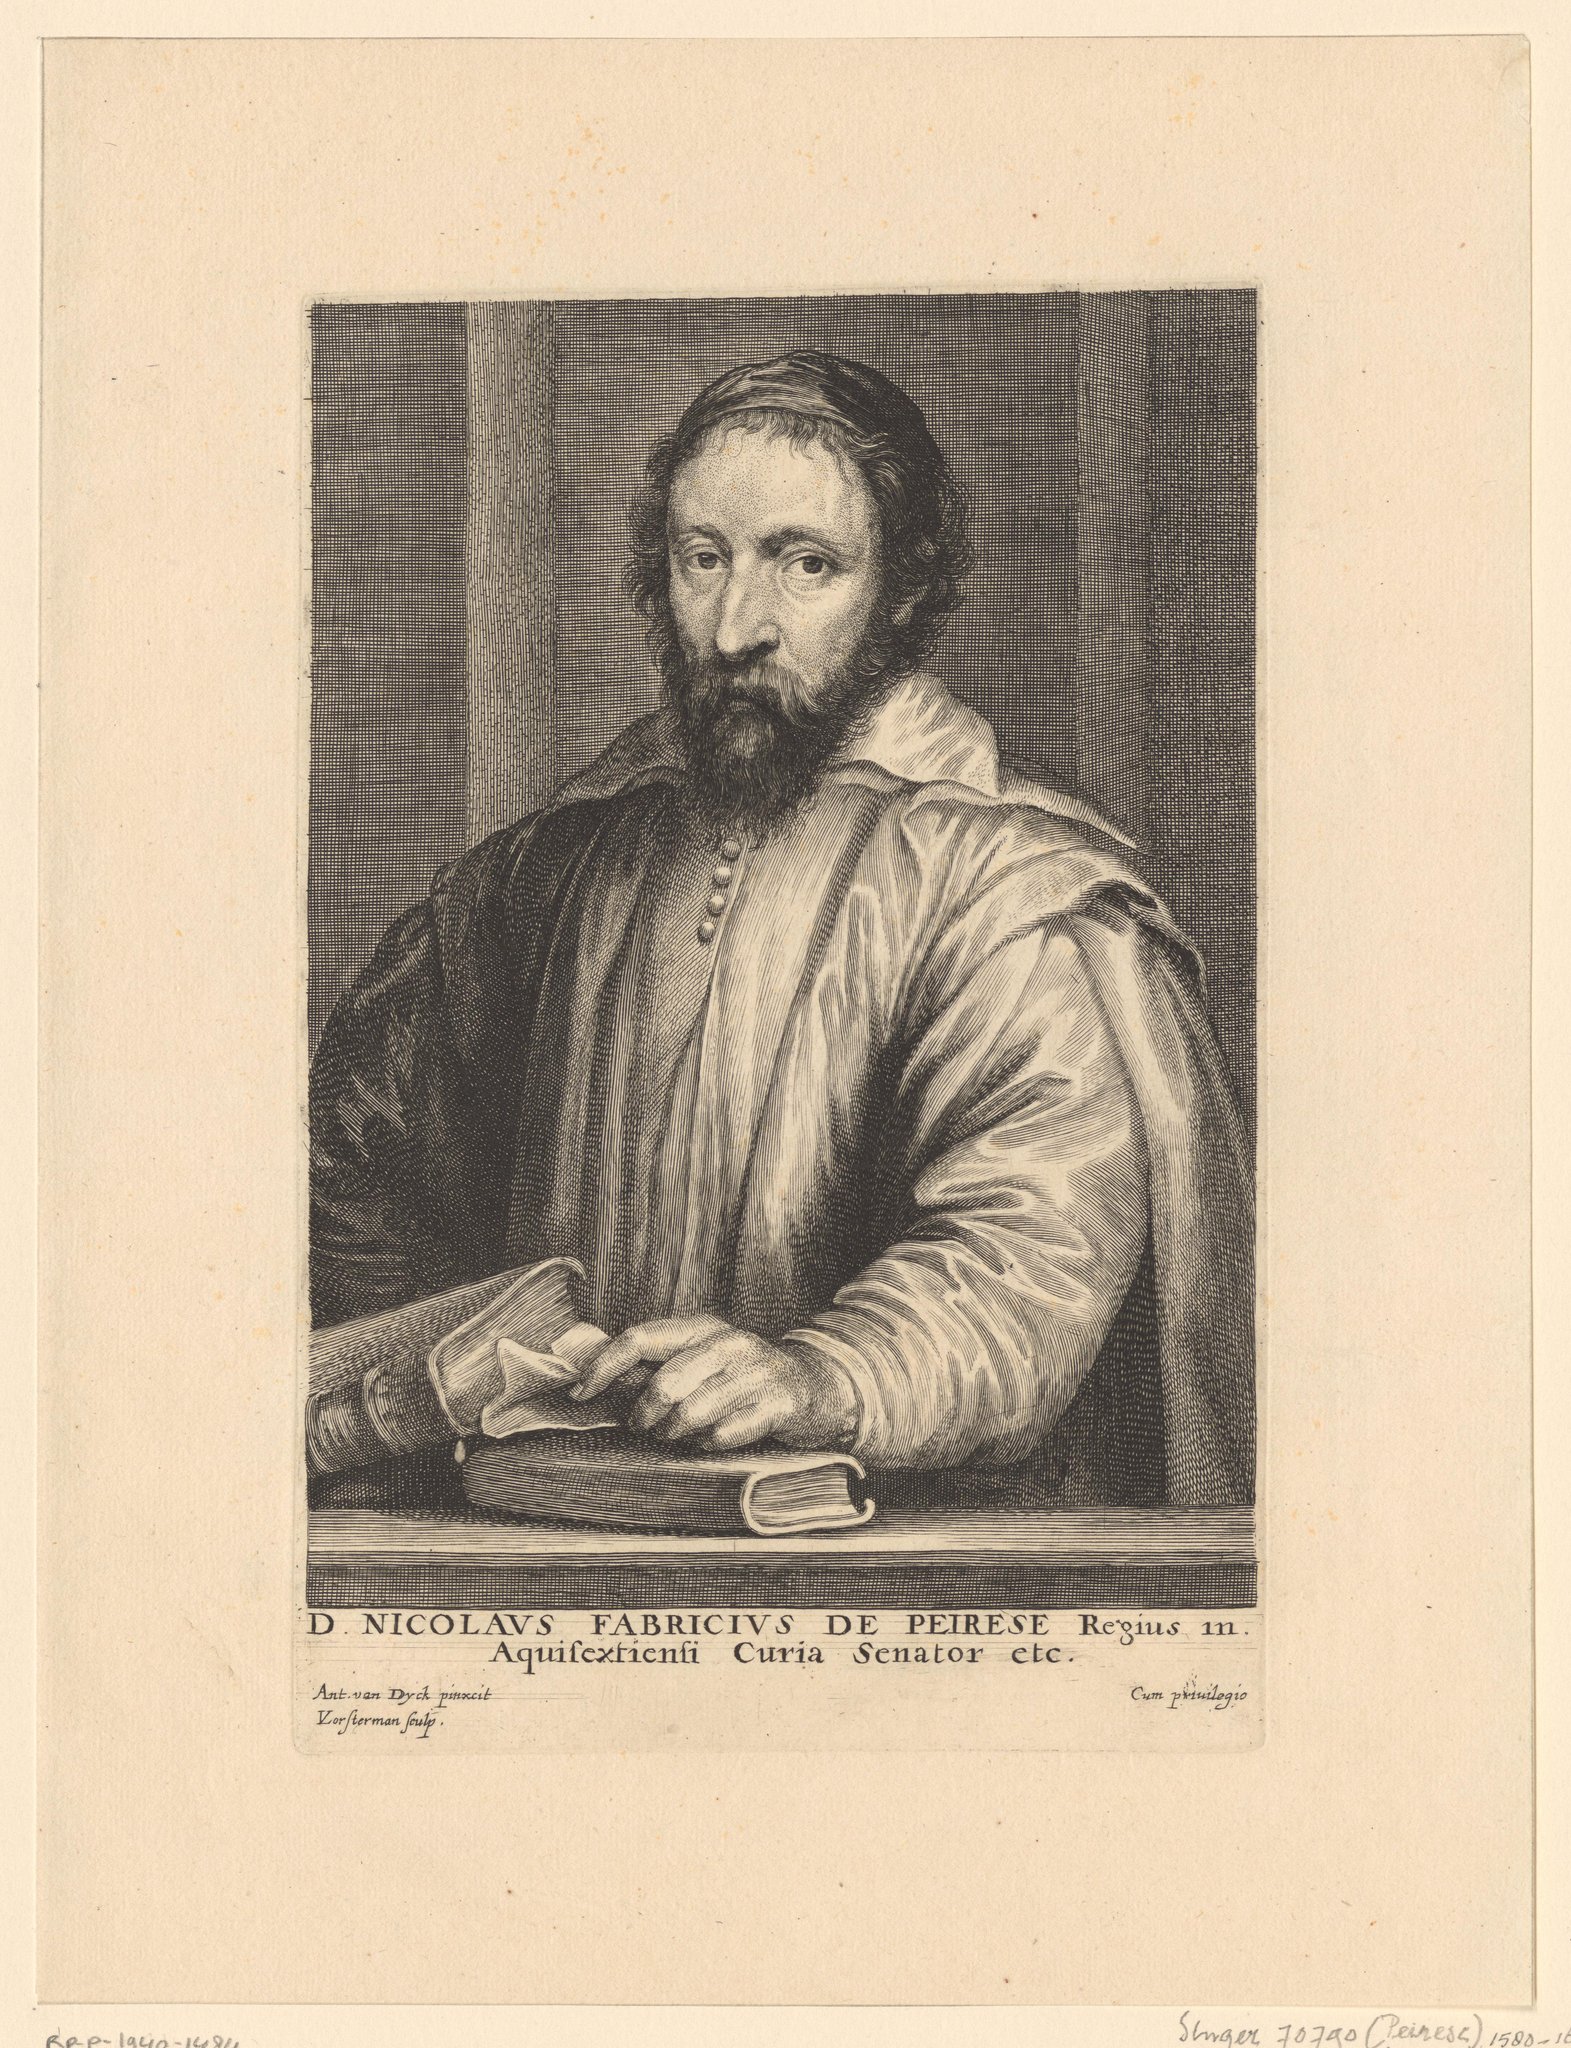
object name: print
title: Portret van Nicolas-Claude Fabri de Peiresc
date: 1645-1646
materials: paper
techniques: engraving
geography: antwerp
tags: nicolas-claude fabri de peiresc, adult man, historical persons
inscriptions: collector's mark: Lugt 2228, collector's mark: Lugt 2760, collector's mark: Lugt 2166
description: Prent mogelijk uit: Icones principum, virorum doctorum, pictorum, chalcographorum, statuariorum nec non amatorum pictoriae artis numero centum ab Ant. van Dyck ad vivum expressae ejusque sumptibus aeri incisae. Antwerpen: Gillis Hendricx, [1645-1646].